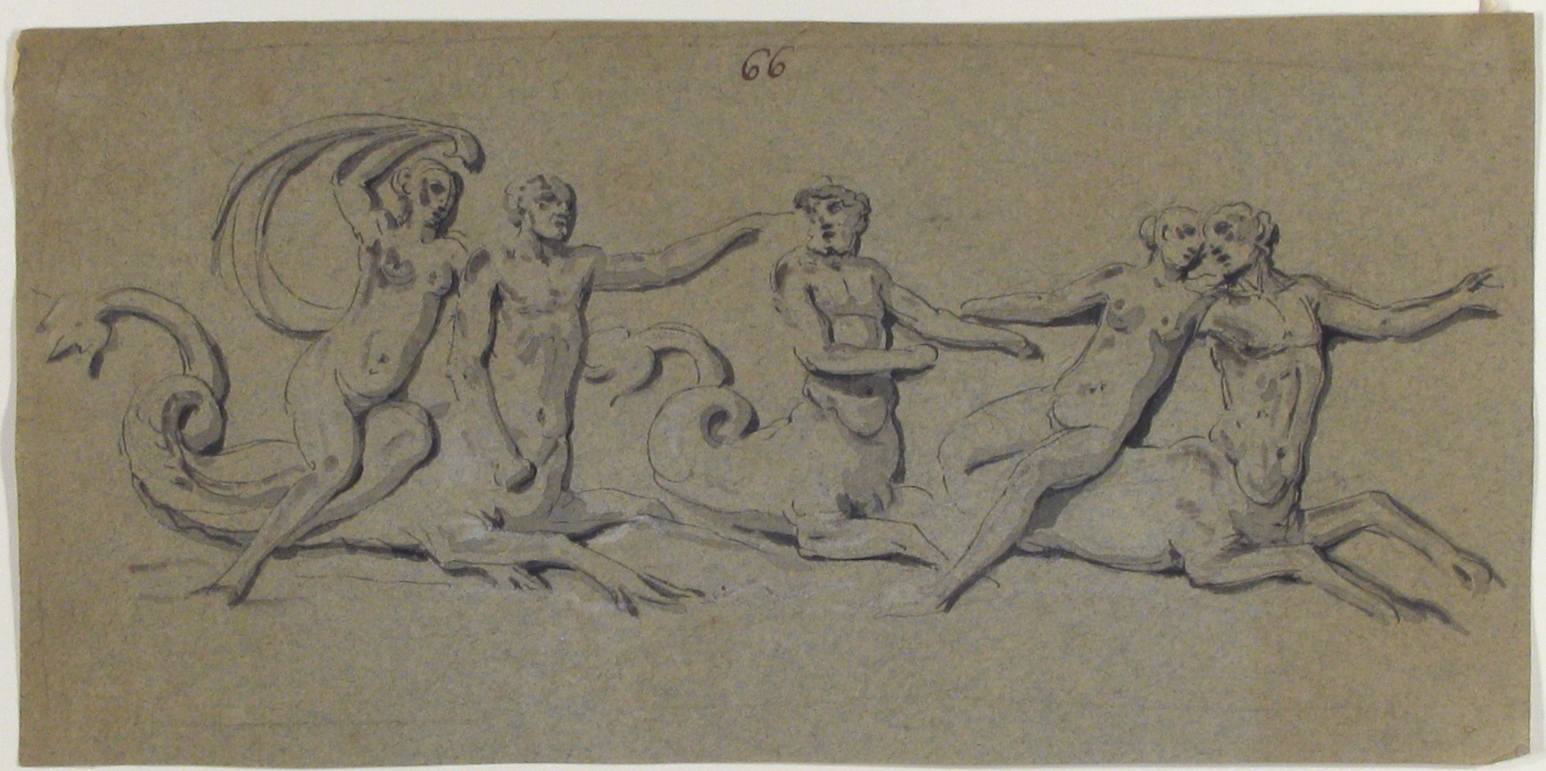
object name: drawing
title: Nereids and Tritons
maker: anonymous, french, 18th century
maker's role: artist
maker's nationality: french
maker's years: 1700-1800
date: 1701-1800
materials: ink, paper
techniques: brush, heightening, pen, wash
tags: female nudes,triton,nymphs